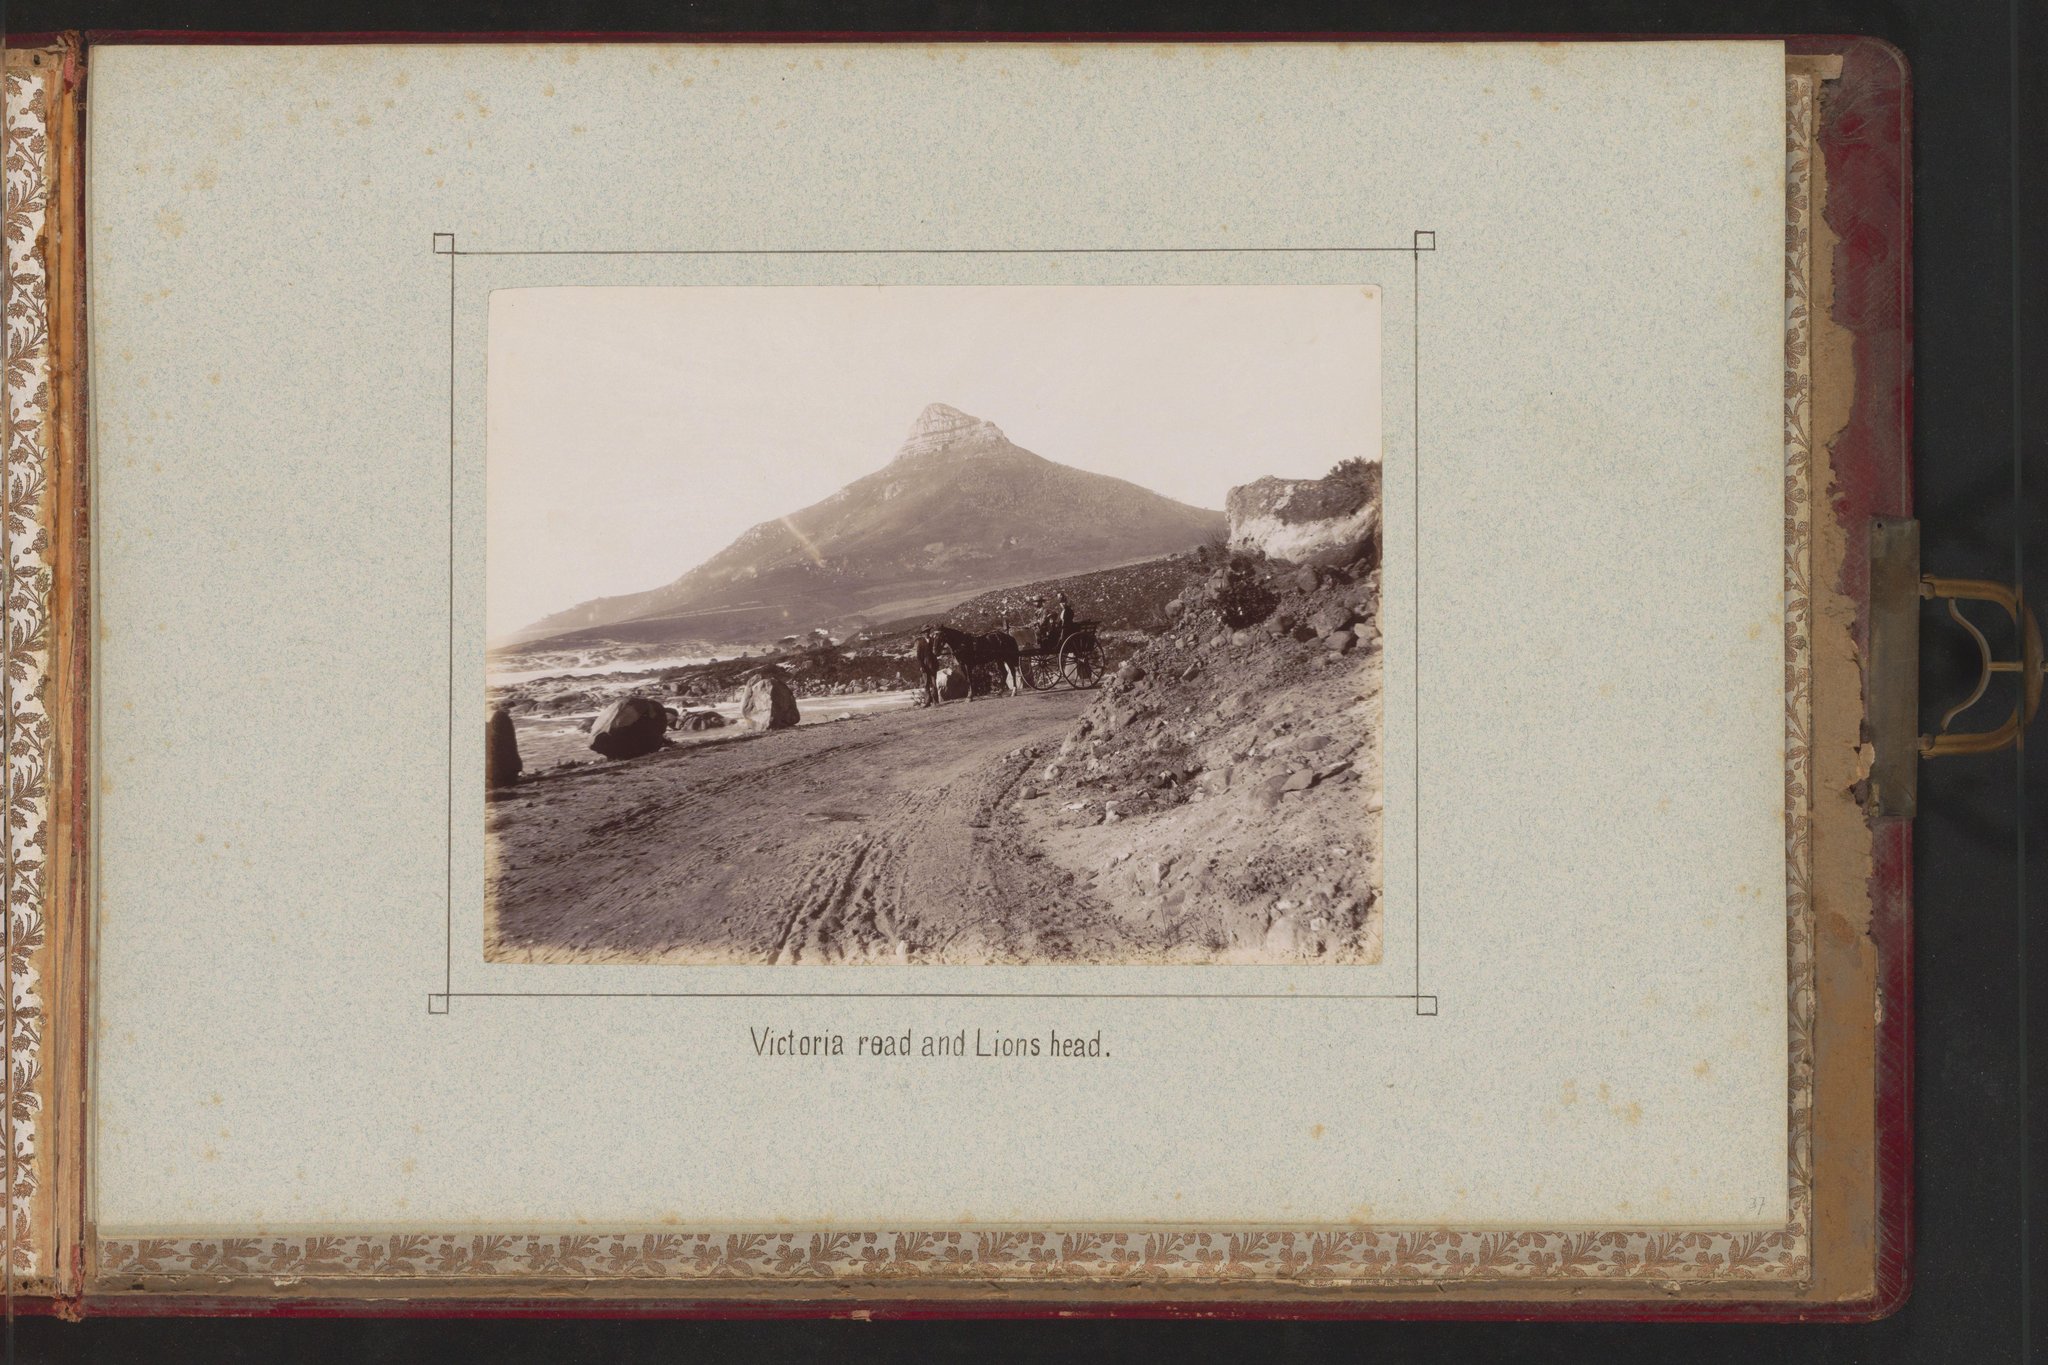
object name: photograph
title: Rijtuig op Victoria Road met op de achtergrond de Leeukop (Lion's Head) bij Kaapstad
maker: Anonymous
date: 1880-1900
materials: photographic support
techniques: albumen print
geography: cape town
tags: mountain-top, peak (+ landscape with figures, staffage)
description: Onderdeel van Reisalbum met foto's van Zuid-Afrika, Madeira, Portugal, Frankrijk en Duitsland.